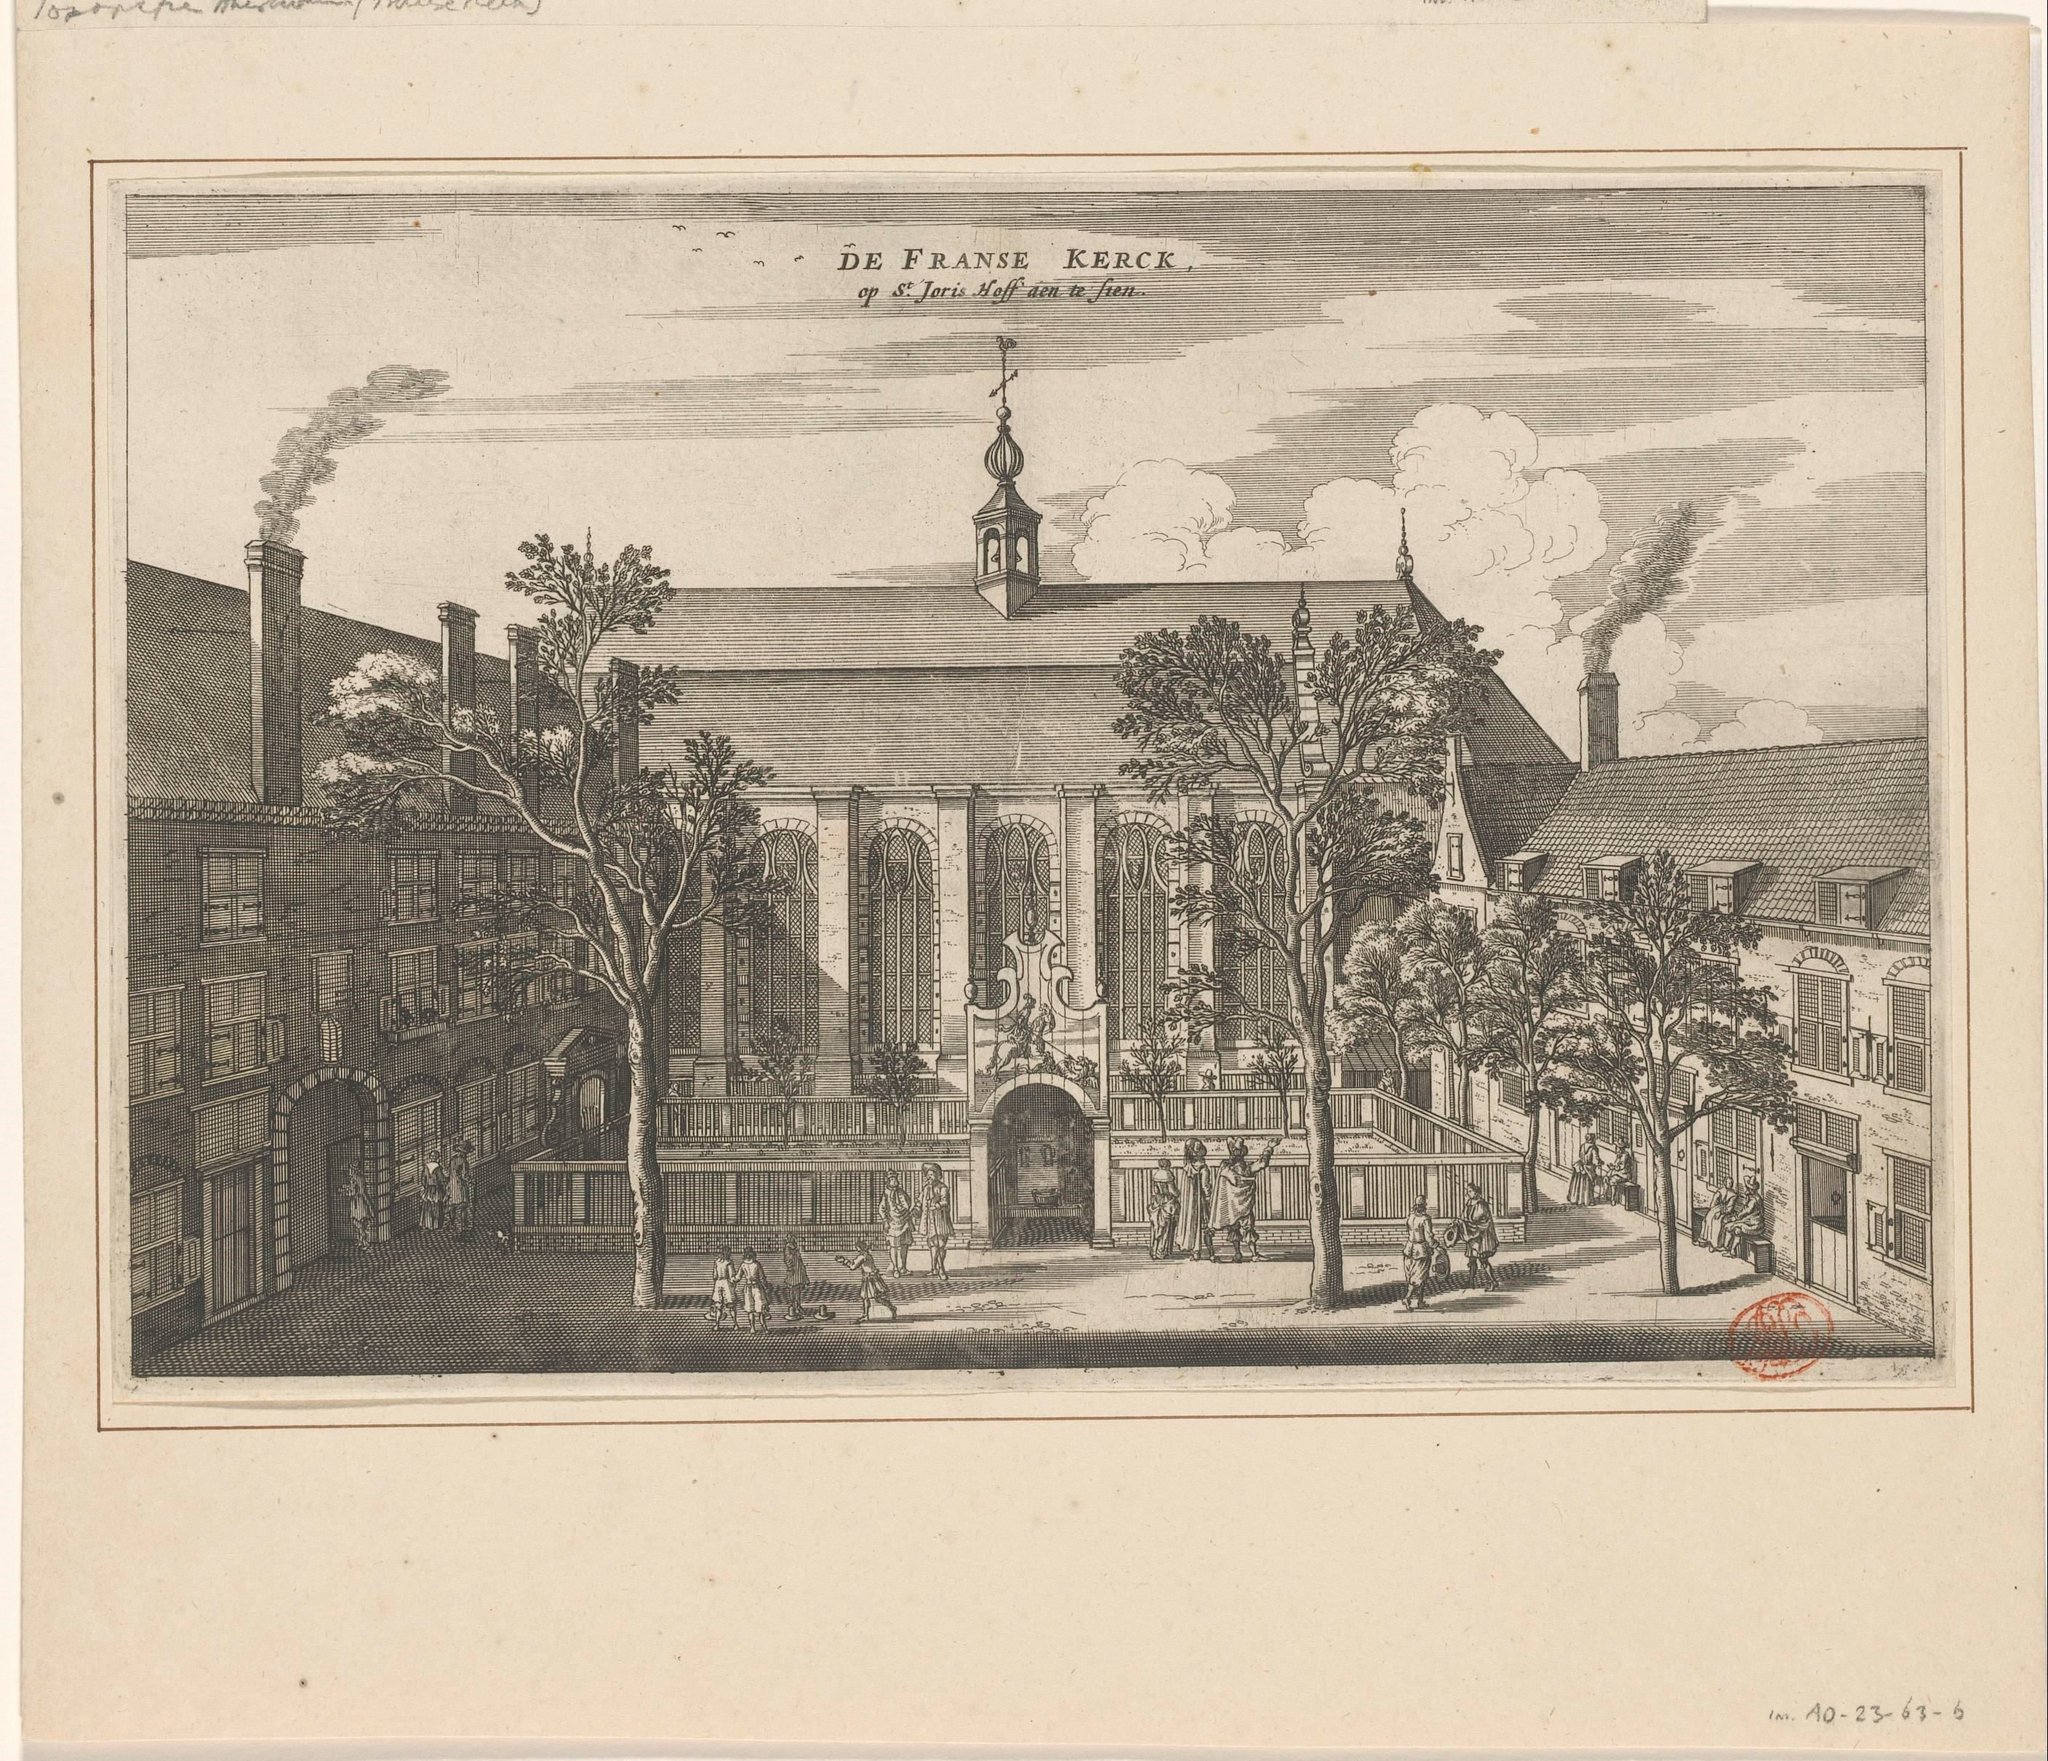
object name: print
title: Gezicht op de Waalse Kerk en het Sint-Jorishof te Amsterdam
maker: jacob van meurs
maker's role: draughtsman, print maker, publisher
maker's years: 1619-1680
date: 1663-1664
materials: paper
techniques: engraving, etching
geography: amsterdam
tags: alms-house (dutch: 'hofje'), church (exterior), courtyard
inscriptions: collector's mark: Lugt 195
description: Huidige staat van prent ook gebruikt in: Dapper, Olfert. Historische beschryving der stadt Amsterdam: waer in de voornaemste geschiedenissen (na een kort verhael van gansch Hollant en d'omleggende dorpen (…). Amsterdam: Jacob van Meurs, 1663.* En in: Zesen, Philipp von. Beschreibung der Stadt Amsterdam: darinnen von derselben ersten Ursprunge bis auf gegenwärtigen Zustand (…). Amsterdam: Joachim Nosche, 1664. * In sommige exemplaren van deze uitgave komt de huidige staat van de prent voor. In andere exemplaren is een latere staat ingebonden, waarop boven de Nederlandse een Franse titel is toegevoegd.